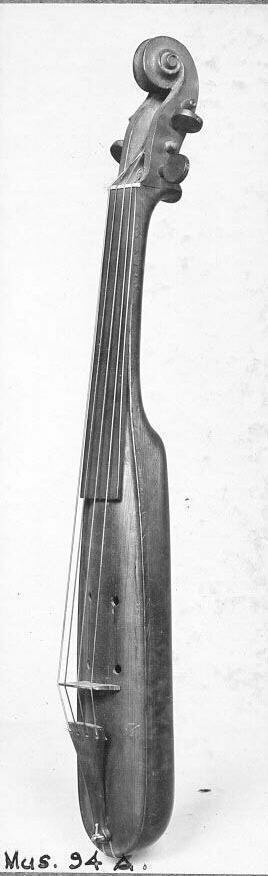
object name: pochette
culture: french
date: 1700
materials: wood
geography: france